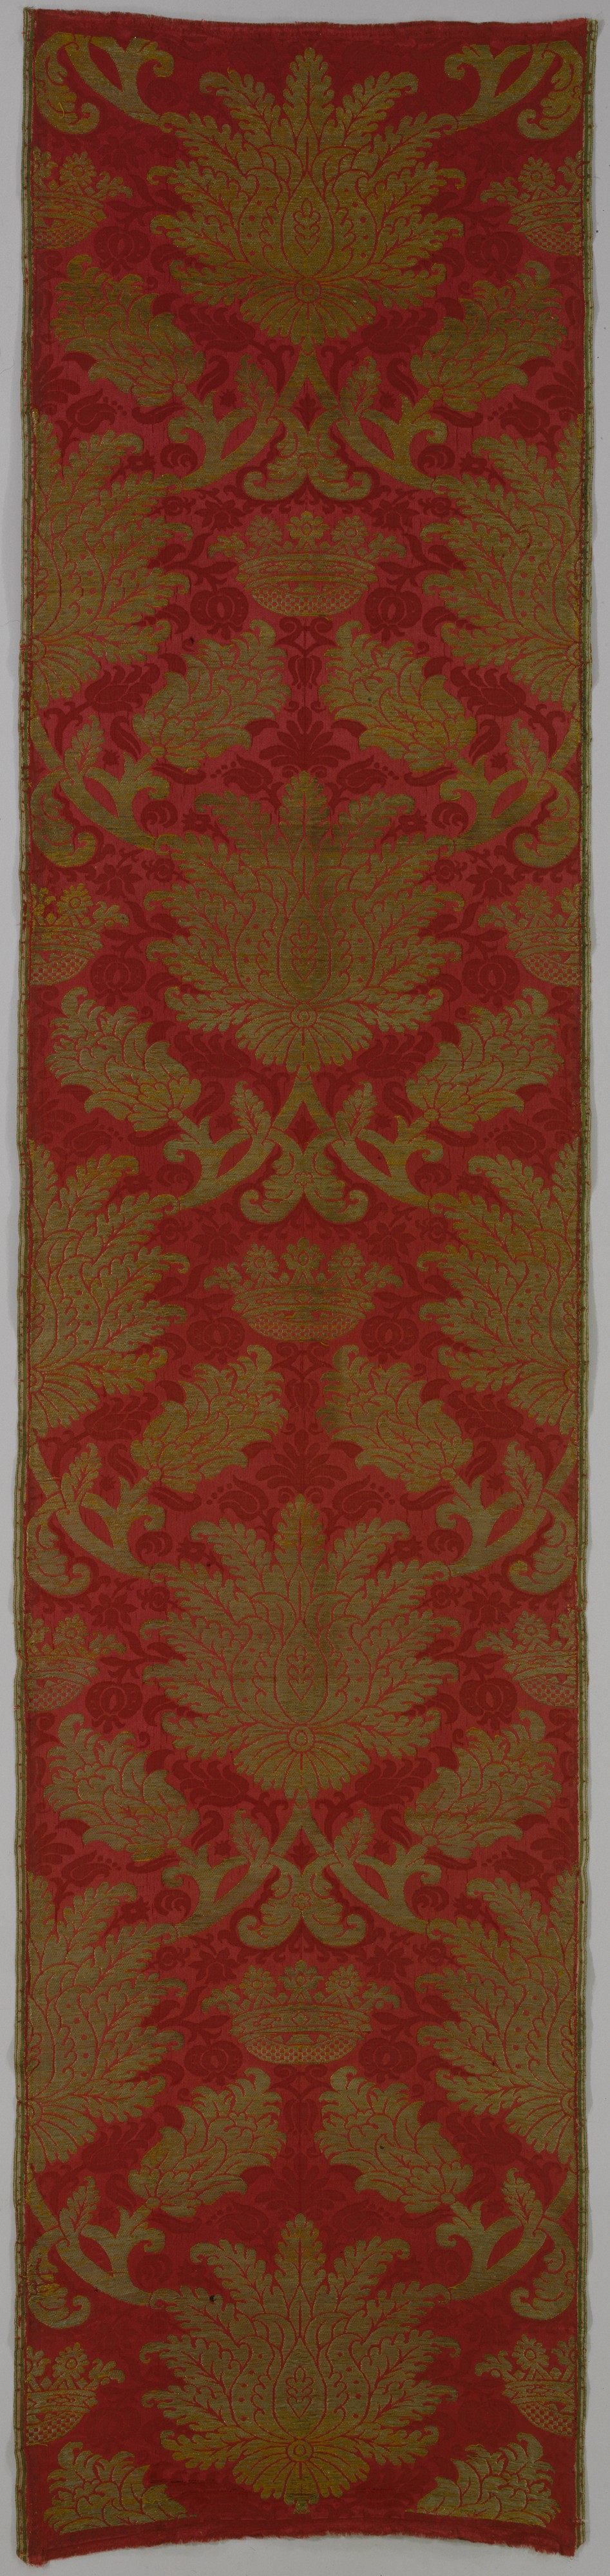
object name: panel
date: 1601-1700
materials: metal thread, silk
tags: flowers